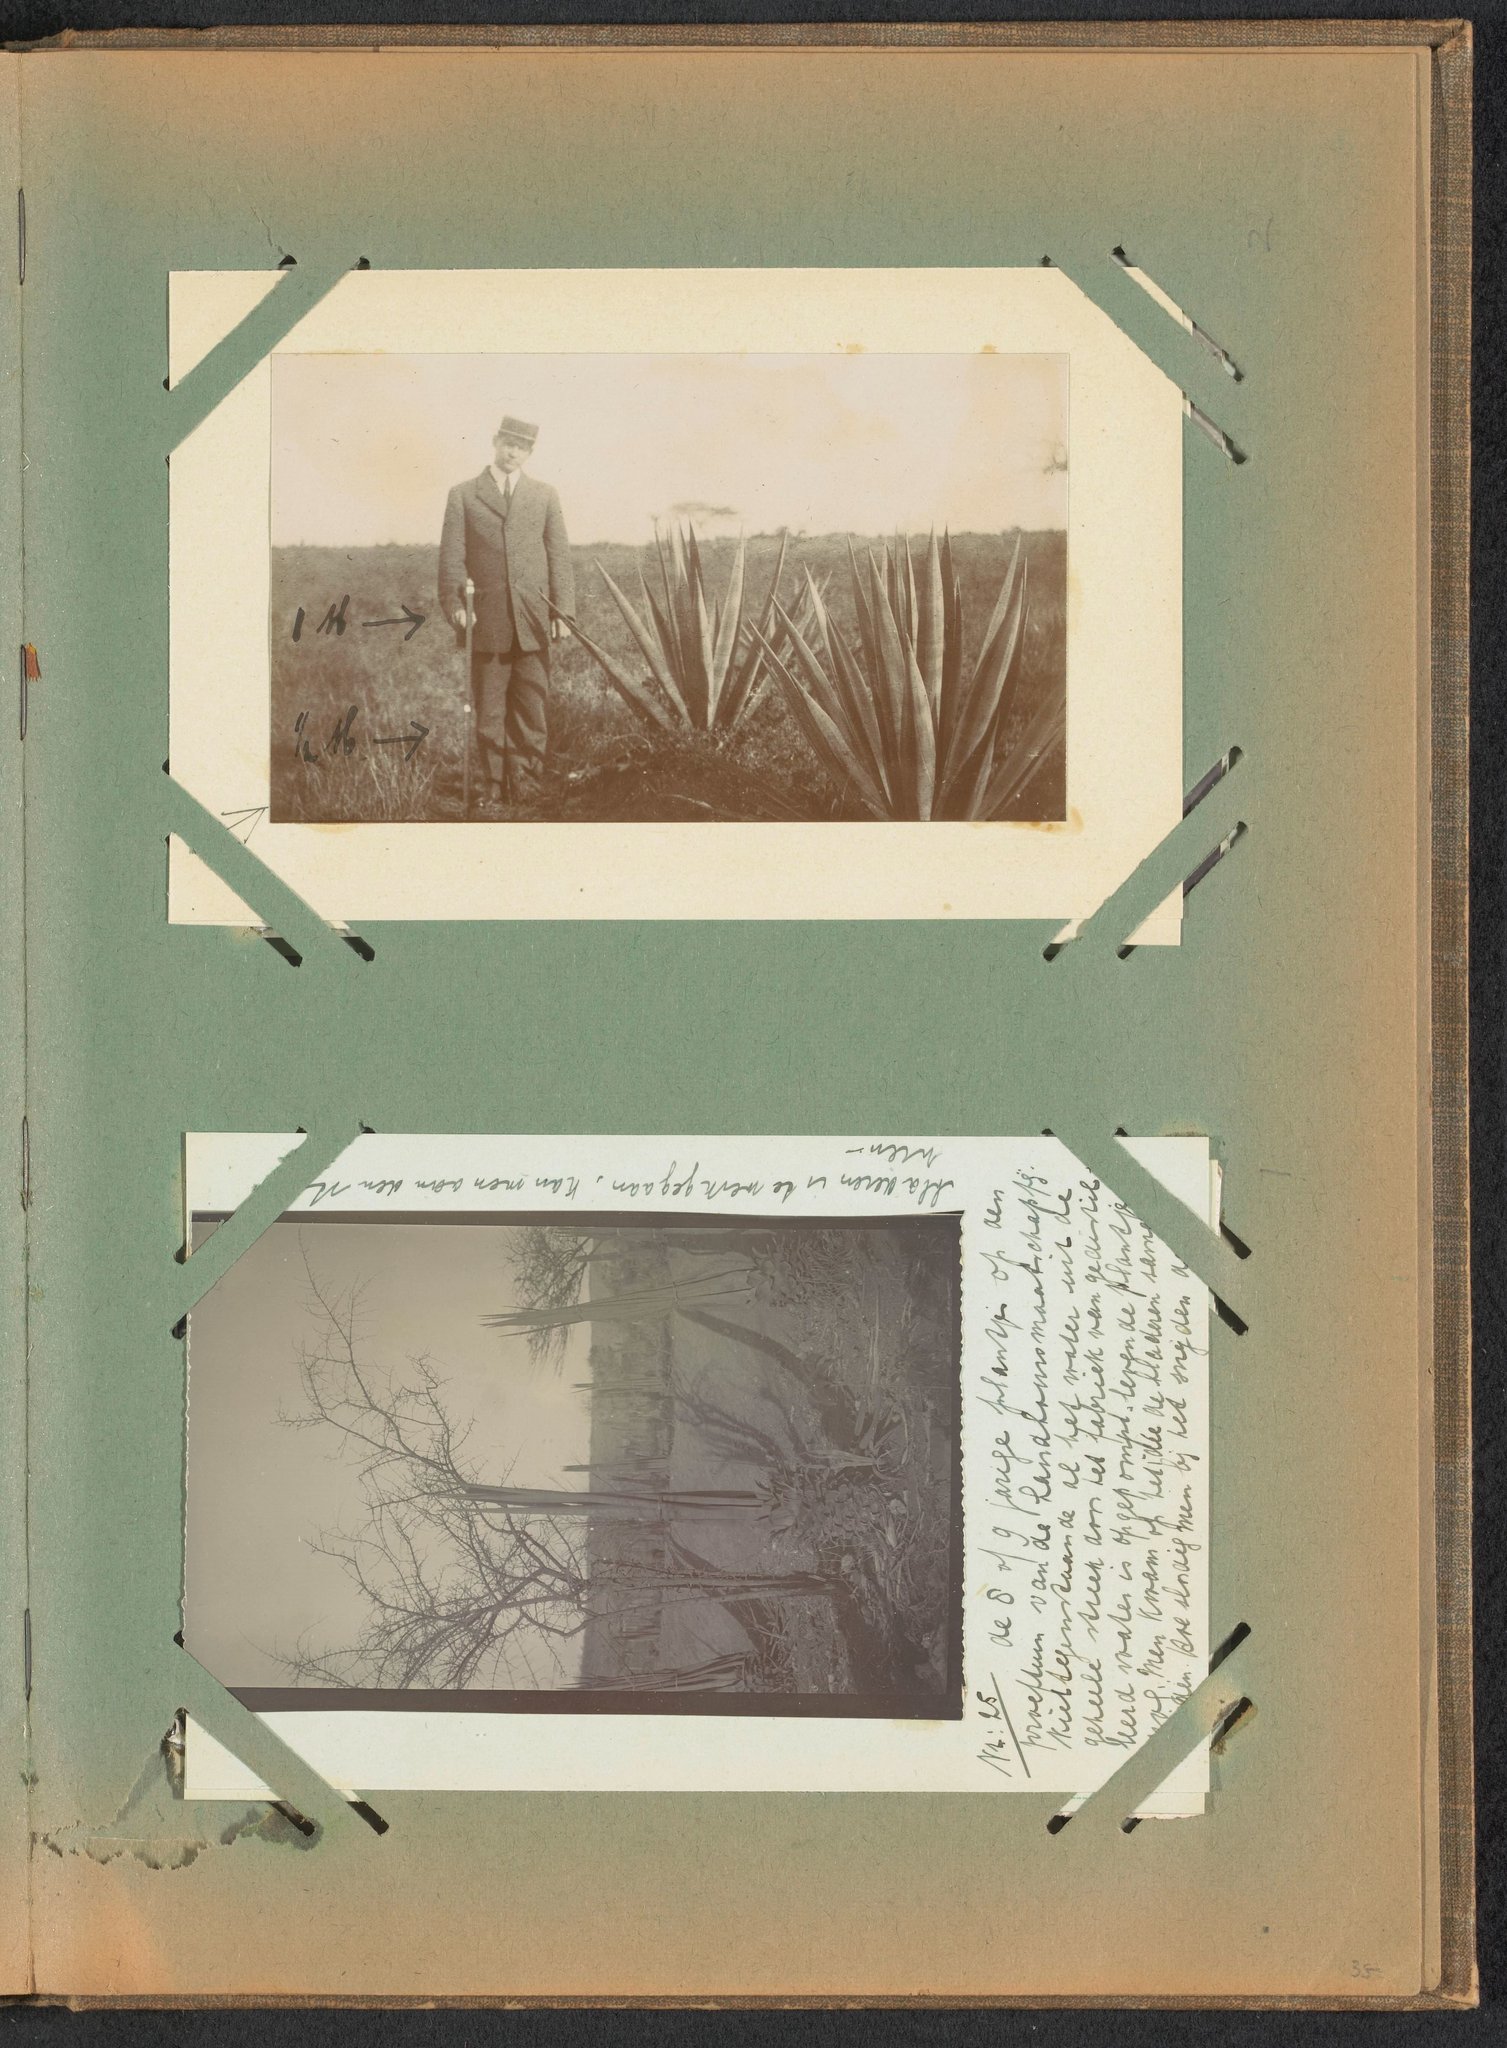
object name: photograph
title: Nr. 25 de 8 of 9 jarige plantjes op een proeftuin van de landbouw maatschappij (...)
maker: Anonymous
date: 1912-1913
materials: paper, photographic support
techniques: gelatin silver print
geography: curacao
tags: plantation, (non-fruit) products of plants or trees: sisal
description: Sisalplanten in een proeftuin van Plantage Mount Pleasant op Curaçao. Onderdeel van het fotoalbum uit ca. 1912-1913 met 92 foto's van de plantages Peperpot en Dordrecht in Suriname en Mount Pleasant op Curaçao.